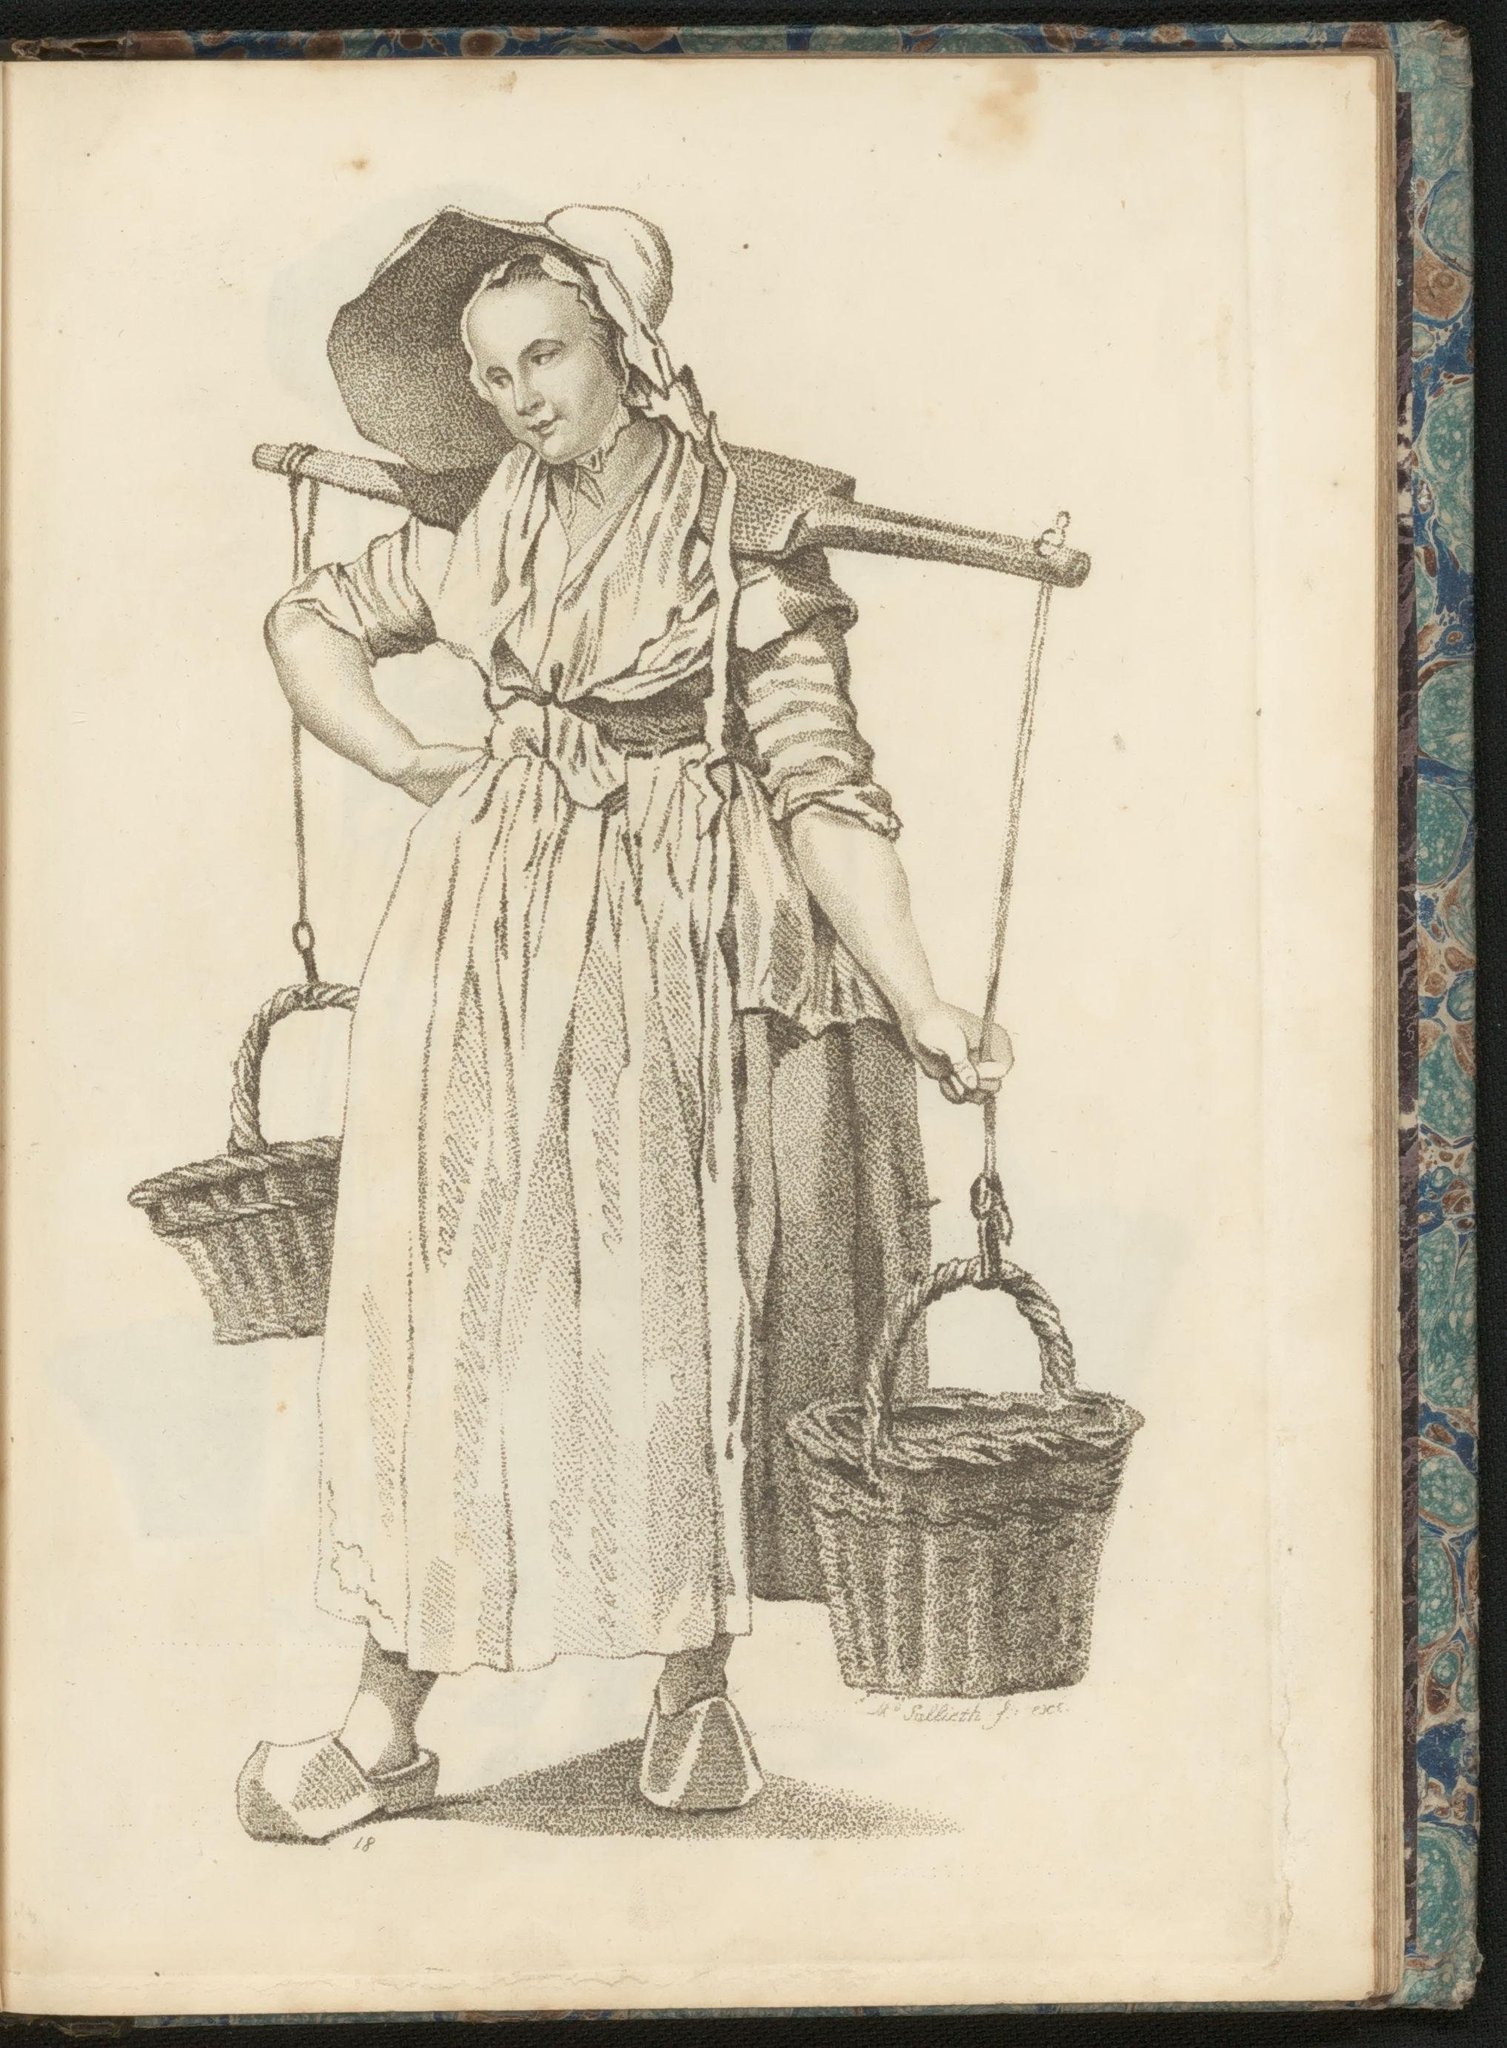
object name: print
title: Boerenvrouw met twee manden aan een juk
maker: mathias de sallieth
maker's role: print maker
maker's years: 1749-1791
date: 1772-1791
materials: paper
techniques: printmaking, etching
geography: rotterdam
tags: farmers - aa - female farmer, farmer's wife, container made of plant material other than wood: basket, carrying something with yoke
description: De prent verscheen vanaf 1818 tevens als onderdeel van een 33-delige reeks prenten door Mathias de Sallieth, samengebonden in: Perkois, Jacobus, Prins, Johannes Huibert. Verzameling van verschillende gekleede mans- en vrouwenstanden, ter oefening van jonge schilders en liefhebbers. Rotterdam: Johannes Immerzeel, 1818. Alle verso-bladen uit dit prentalbum zijn blanco.